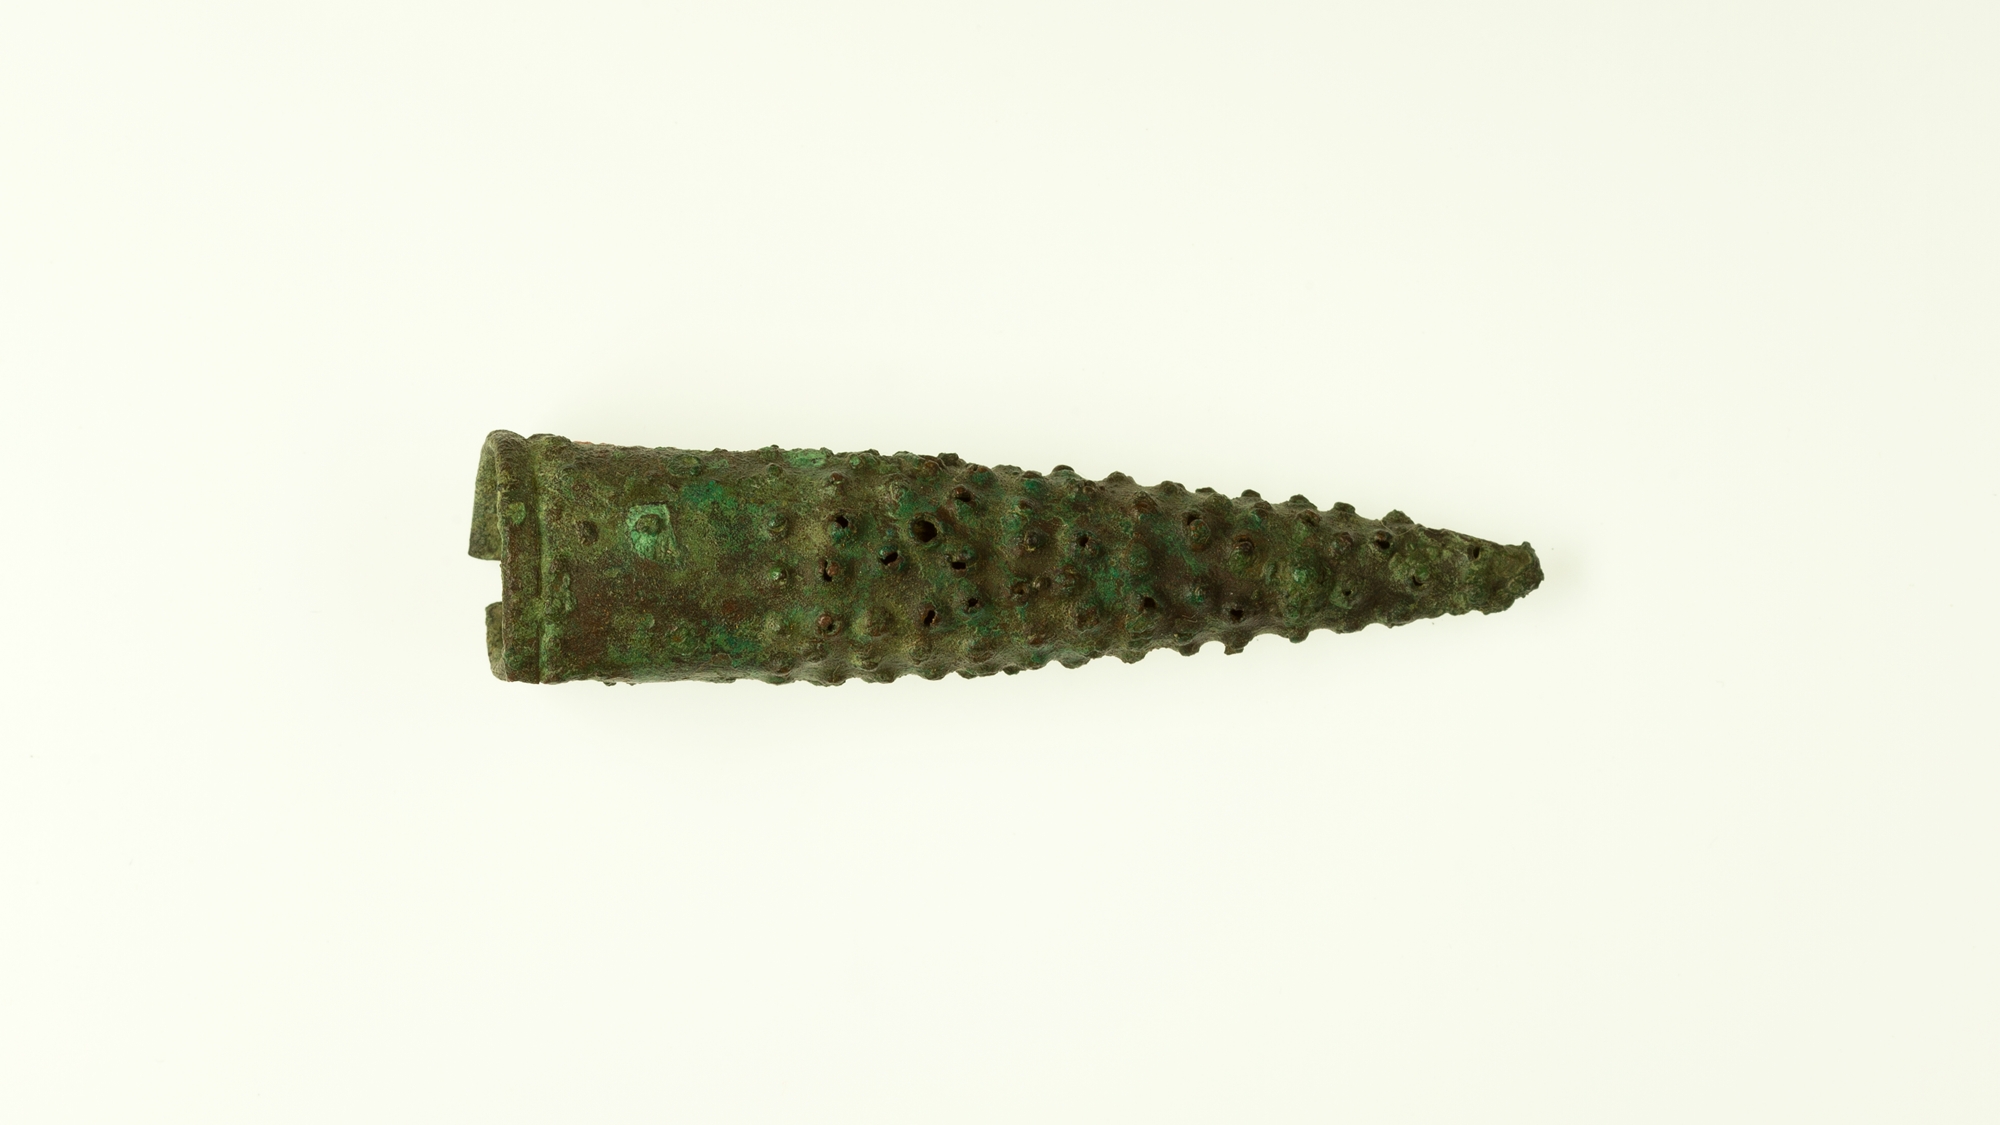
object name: siphon nozzle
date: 1295-1070 BCE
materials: bronze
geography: egypt